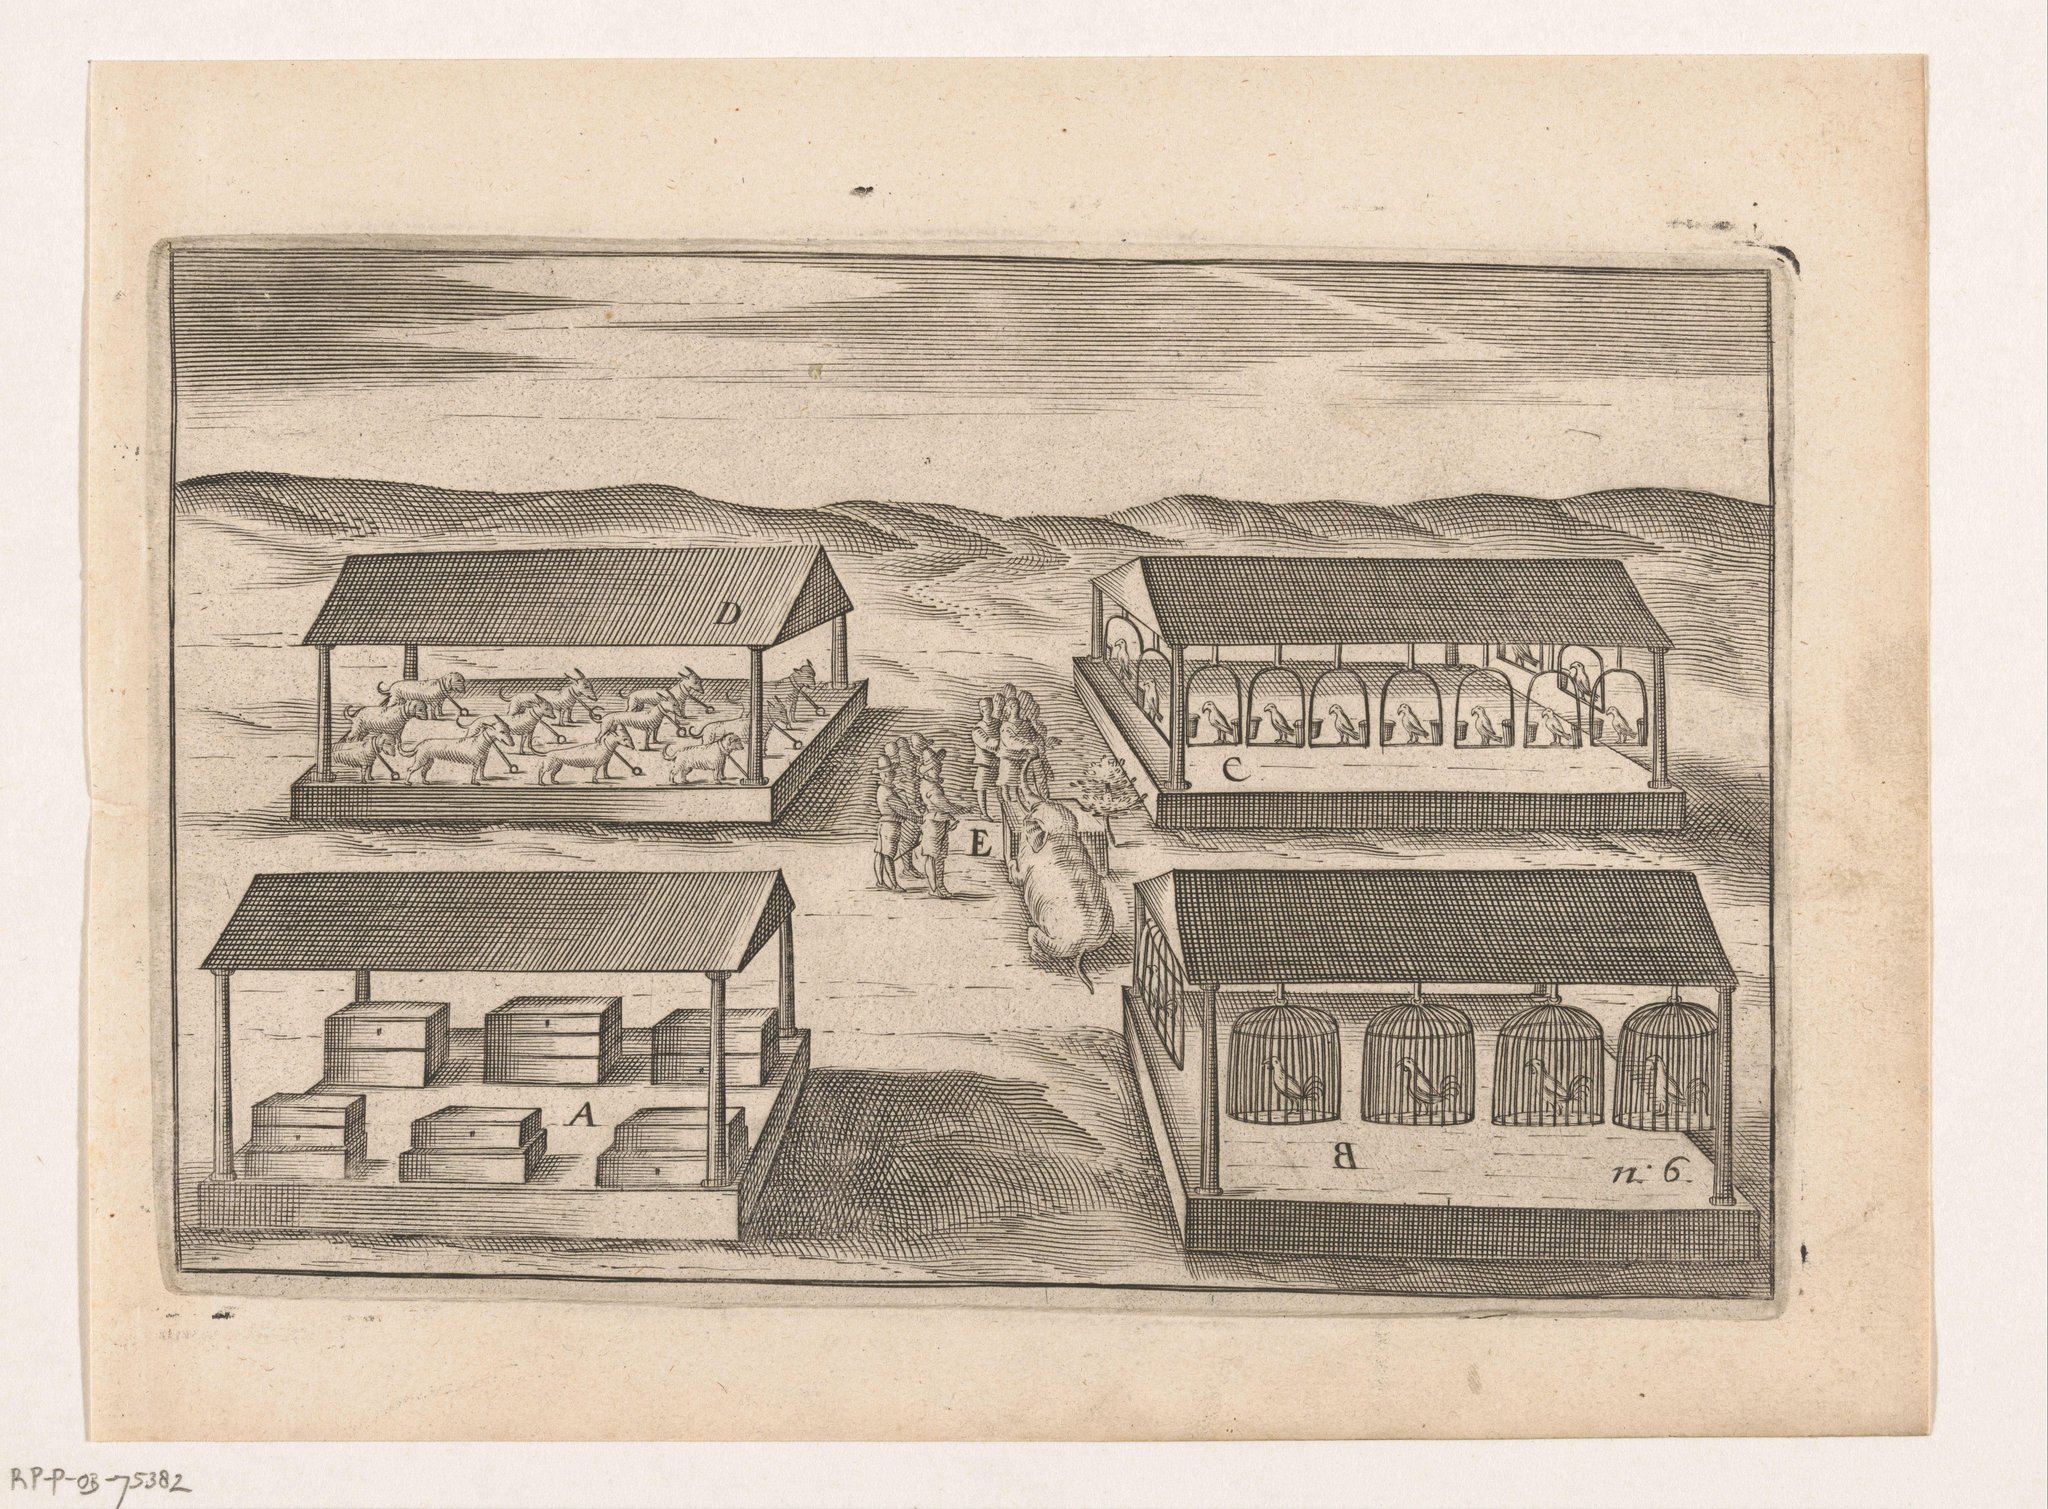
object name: print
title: De dierenverblijven van de koning van Tuban, 1599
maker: Anonymous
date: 1600-1601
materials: paper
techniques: engraving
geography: northern netherlands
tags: mayor, landscapes in tropical and sub-tropical regions, exploration, expedition, voyage of discovery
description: Gebruikt als illustratie eerst in: J. van Neck en W. van Warwijck, Het tweede boeck, iournael oft dagh-register, inhoudende een warachtich verhael ende historische vertellinghe vande reyse, gedaen door de acht schepen van Amstelredamme, gheseylt inden maent martij 1598. onder 't beleydt vanden admirael Iacob Cornelisz. Neck, ende Wybrandt van Warwijck als vice-admirael / Appendix. Vocabulaer vande Javaensche ende Malaysche woorden ..., Cornelis Claes, Amsterdam 1601, plaat No. 21. In deze staat gebruikt in: Oost-Indische ende West-Indische voyagien, Michiel Colijn, Amsterdam 1619 en later in: Waerachtigh verhael van de Schipvaerd op Oost-Indien ghedaen by de acht Schepen in den jare 1598 van Amsterdam uyt-ghezeylt, onder 't beleyd van den Admirael Jacob Cornelissoon van Neck, ende Vice-Admirael Wybrand van Warwijck. Opgenomen in: I. Commelin, Begin ende voortgangh, van de Vereenighde Nederlantsche Geoctroyeerde Oost-Indische Compagnie, J. Janssonius, Amsterdam 1646. Genummerd: 6.